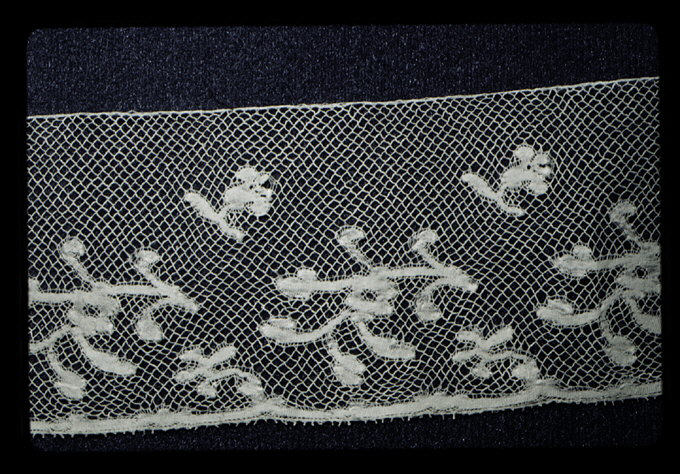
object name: strip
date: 1767-1800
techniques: lace